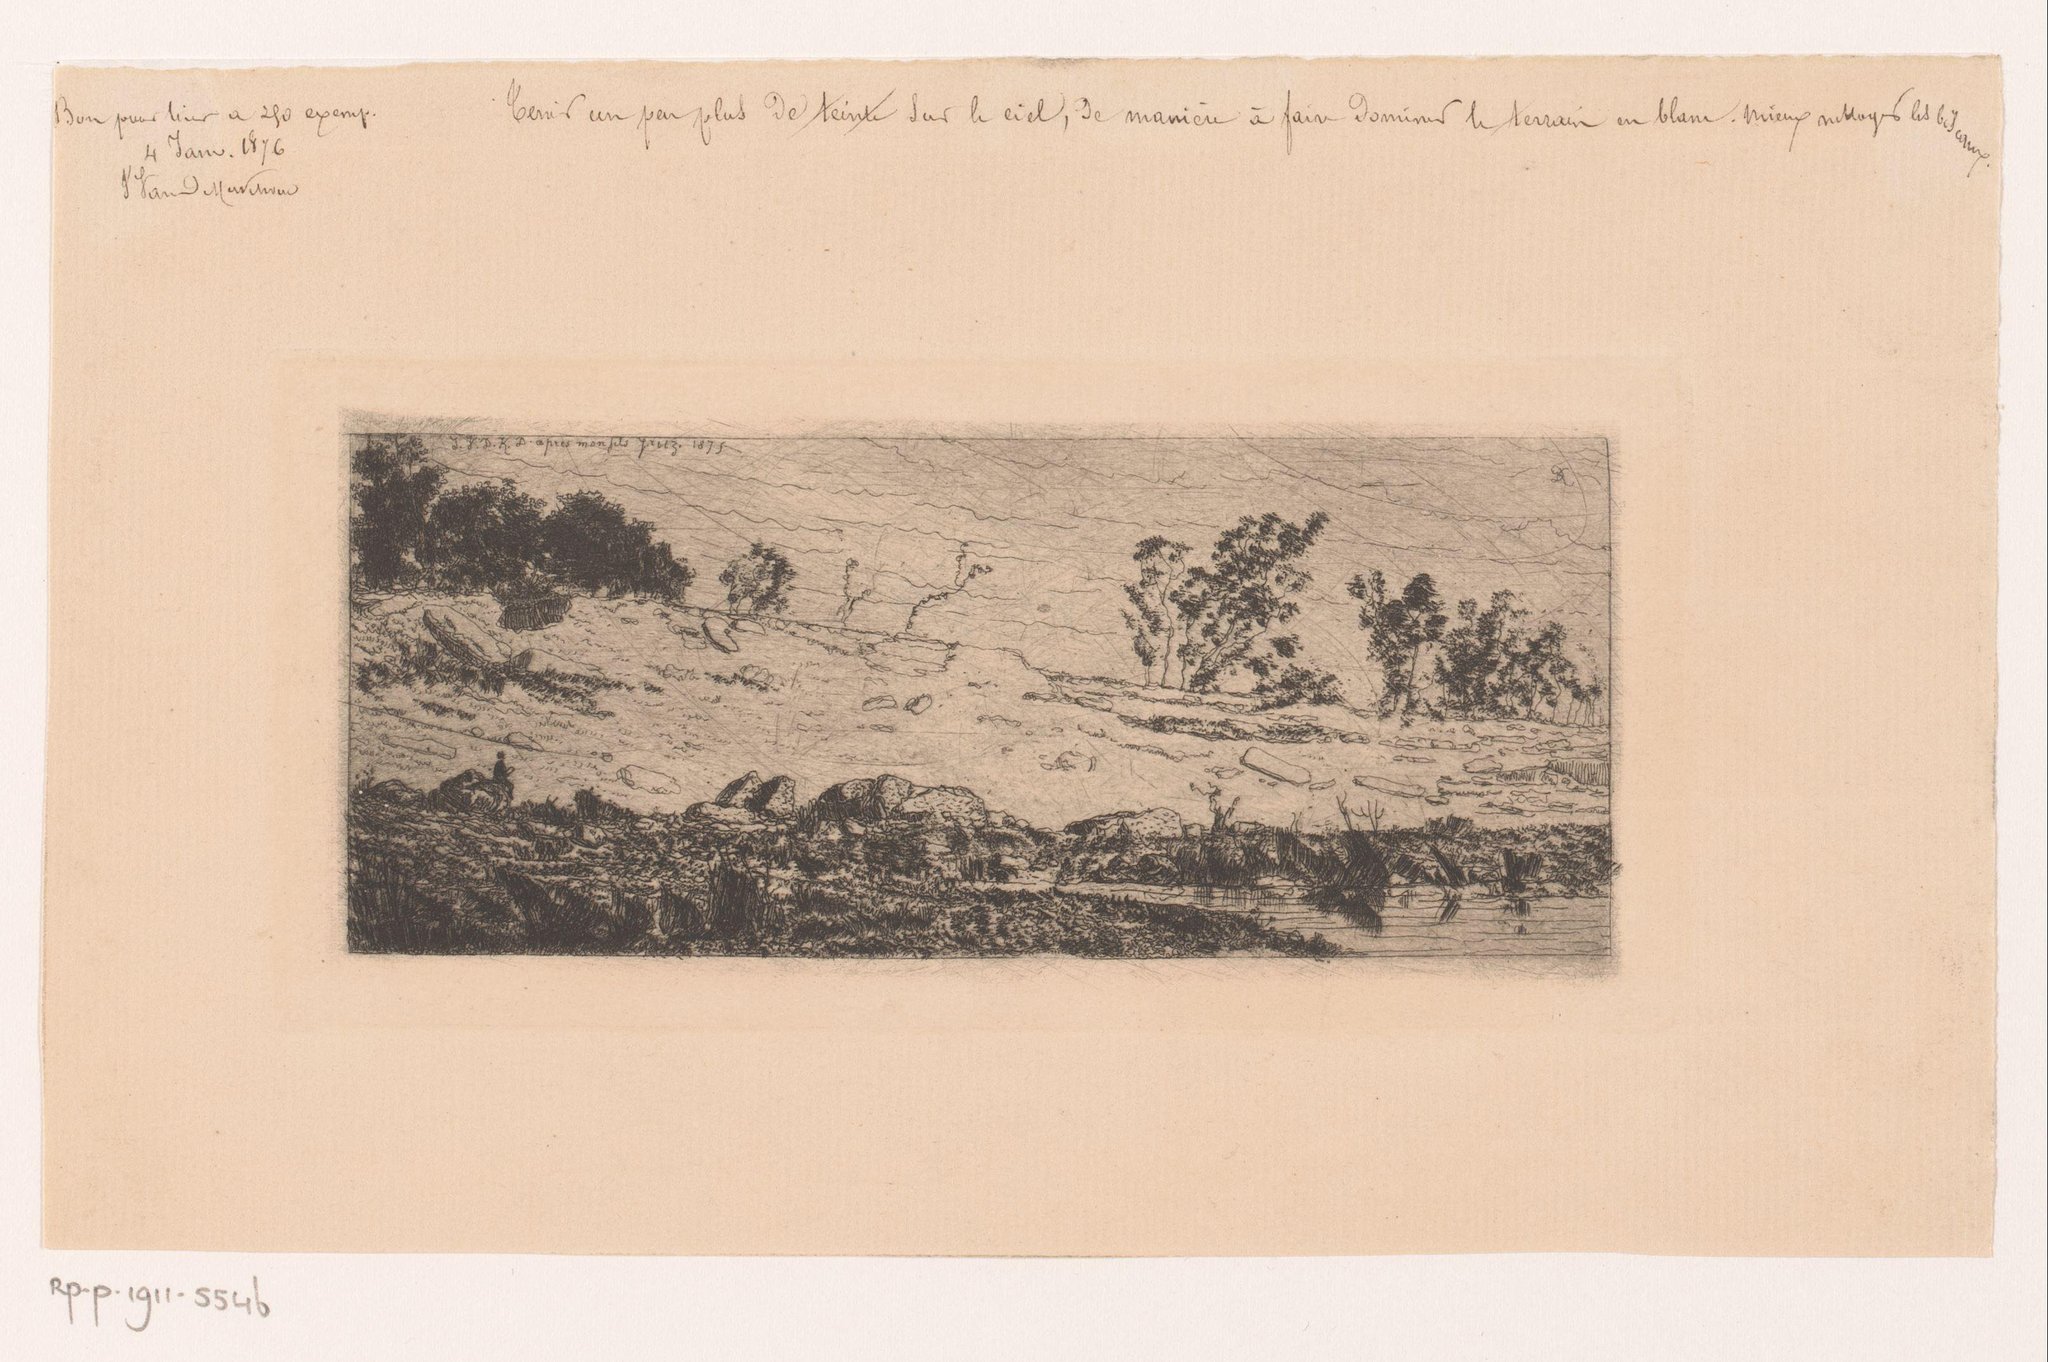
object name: print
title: Glooiend landschap met een meer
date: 1876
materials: paper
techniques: drypoint, etching, intaglio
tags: lake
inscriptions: annotation: ‘Tenir un peu plus de teinte sur le ciel, de manière à faire dominer la terrain en blanc, mieux [....]’, collector's mark: Lugt 2228, annotation: ‘Bon pour tirer a 290 exemplaires. 4 Janv. 1876. [Signatuur]’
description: De etsen naar de schilderijen van Frédéric Van de Kerkhove werden na zijn dood door zijn vader en zuster gemaakt en uitgegeven in twee reeksen. De eerste werd in 1877 uitgegeven door het Journal des Beaux-Arts et de la Littérature: Cahier de 25 Eaux-fortes d'après Frédéric van de Kerkhove, gravées par son père et sa sœur. De tweede reeks van 126 etsen, ook in 1877, werd in Parijs uitgegeven bij A. Lévy onder de titel Cent eaux-fortes gravées par J. Van de Kerkhove d'après les tableaux de Frédéric Van de Kerkhove, mort en 1873 à l'âge de 10 ans et 11 mois.